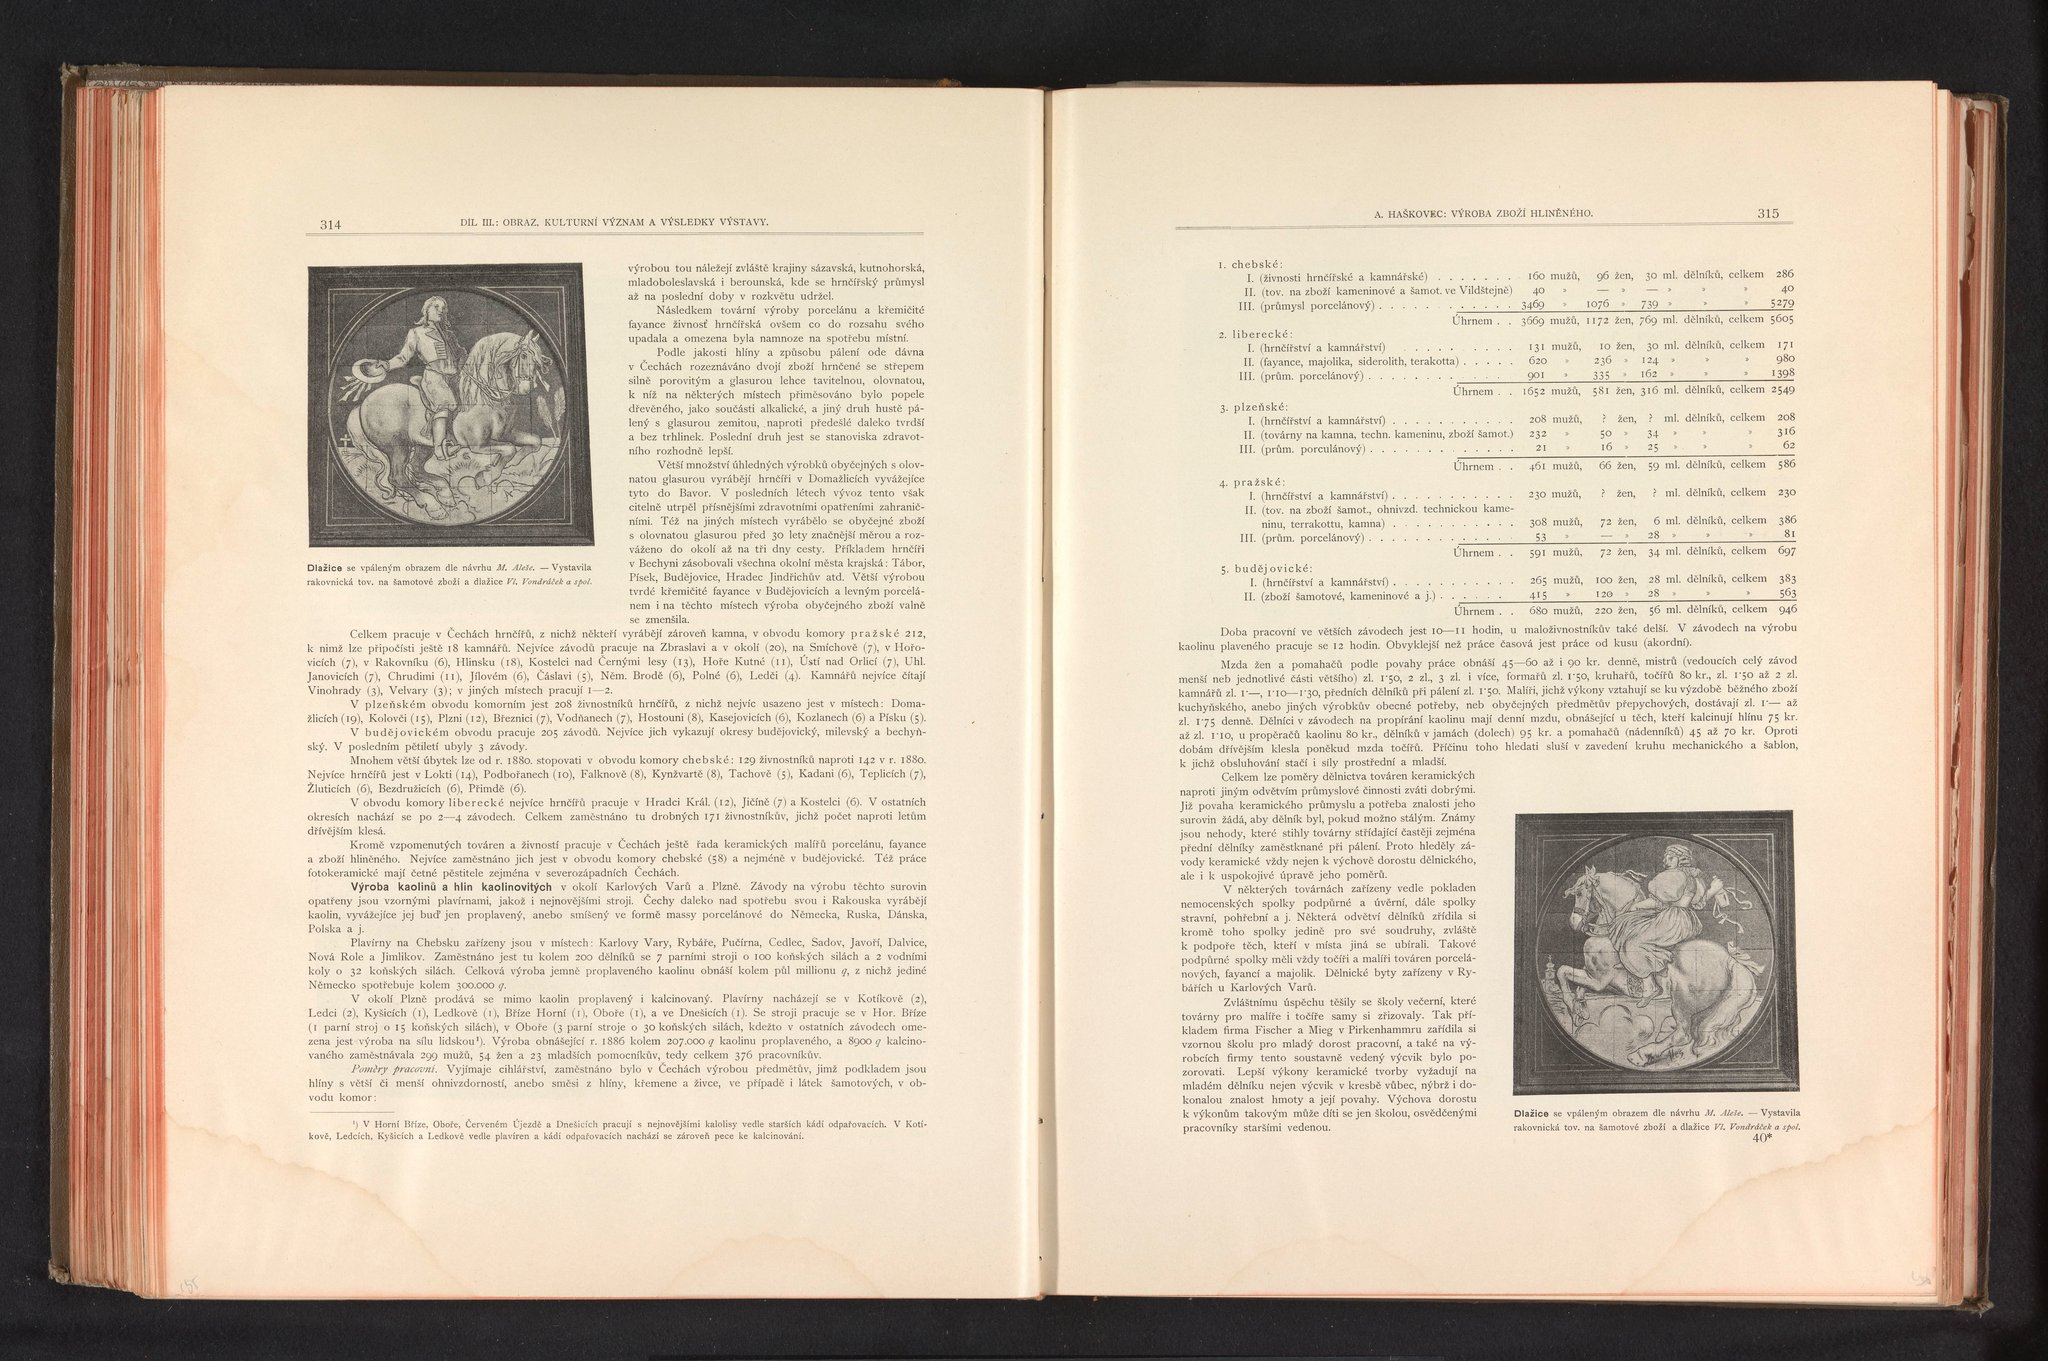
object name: photomechanical print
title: Tegels met een voorstelling van een man op een paard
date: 1890-1895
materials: paper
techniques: autotype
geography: prague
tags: riding a horse, ass, or mule; rider, horseman, tiles, bricks ~ building material